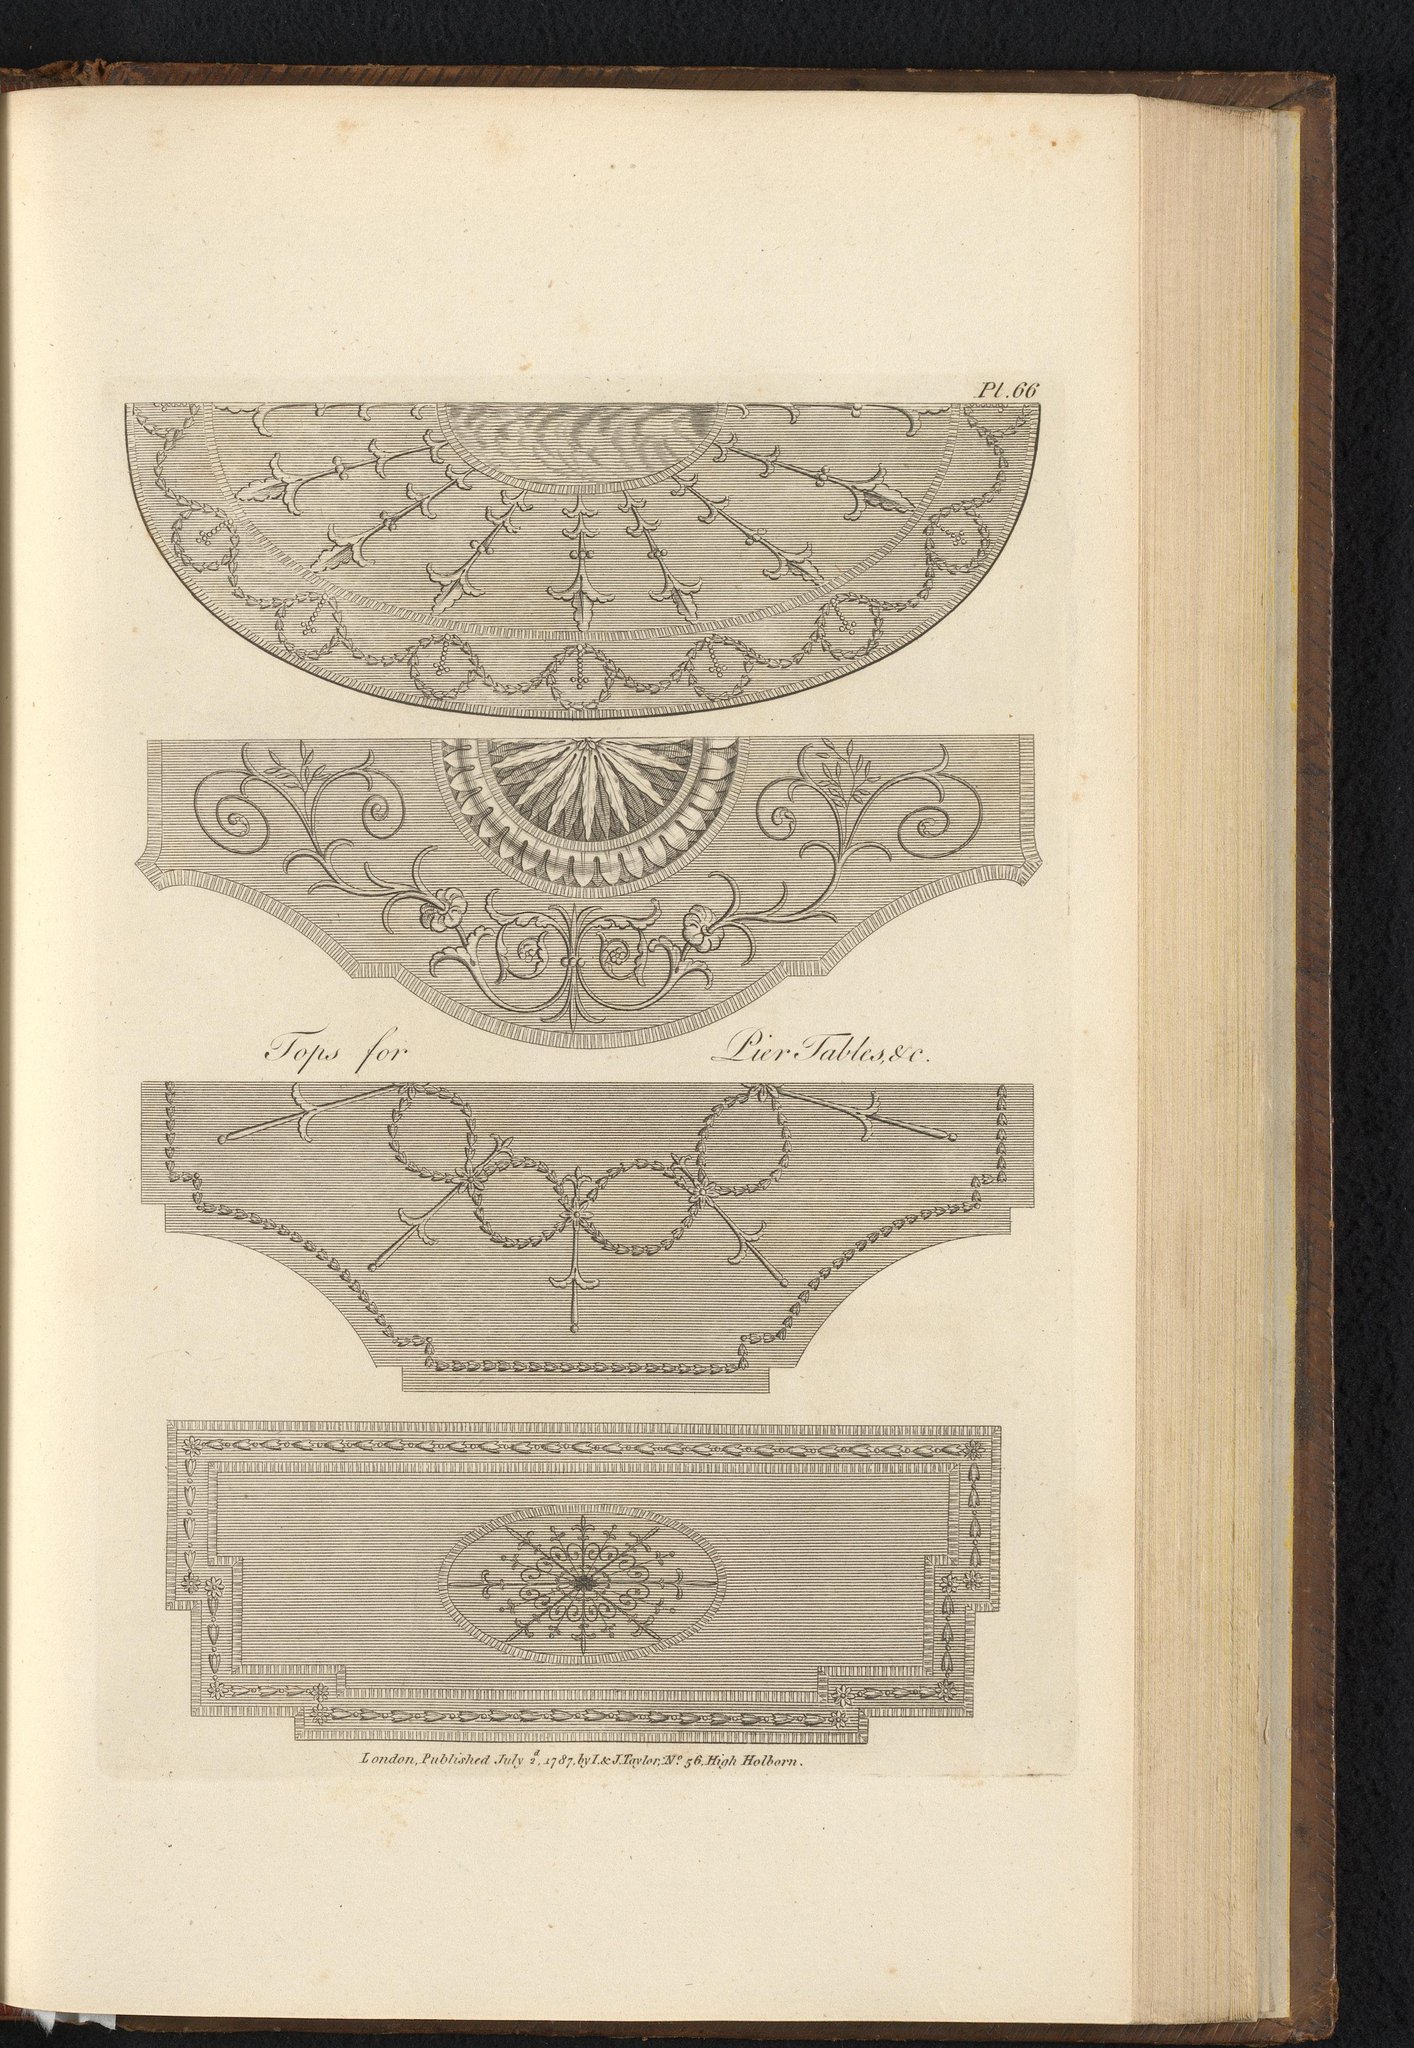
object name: print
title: Bovenaanzichten van vier tafels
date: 1787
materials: paper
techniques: engraving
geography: holborn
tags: table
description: Genummerd: Pl. 66. Prent maakt deel uit van een boek.